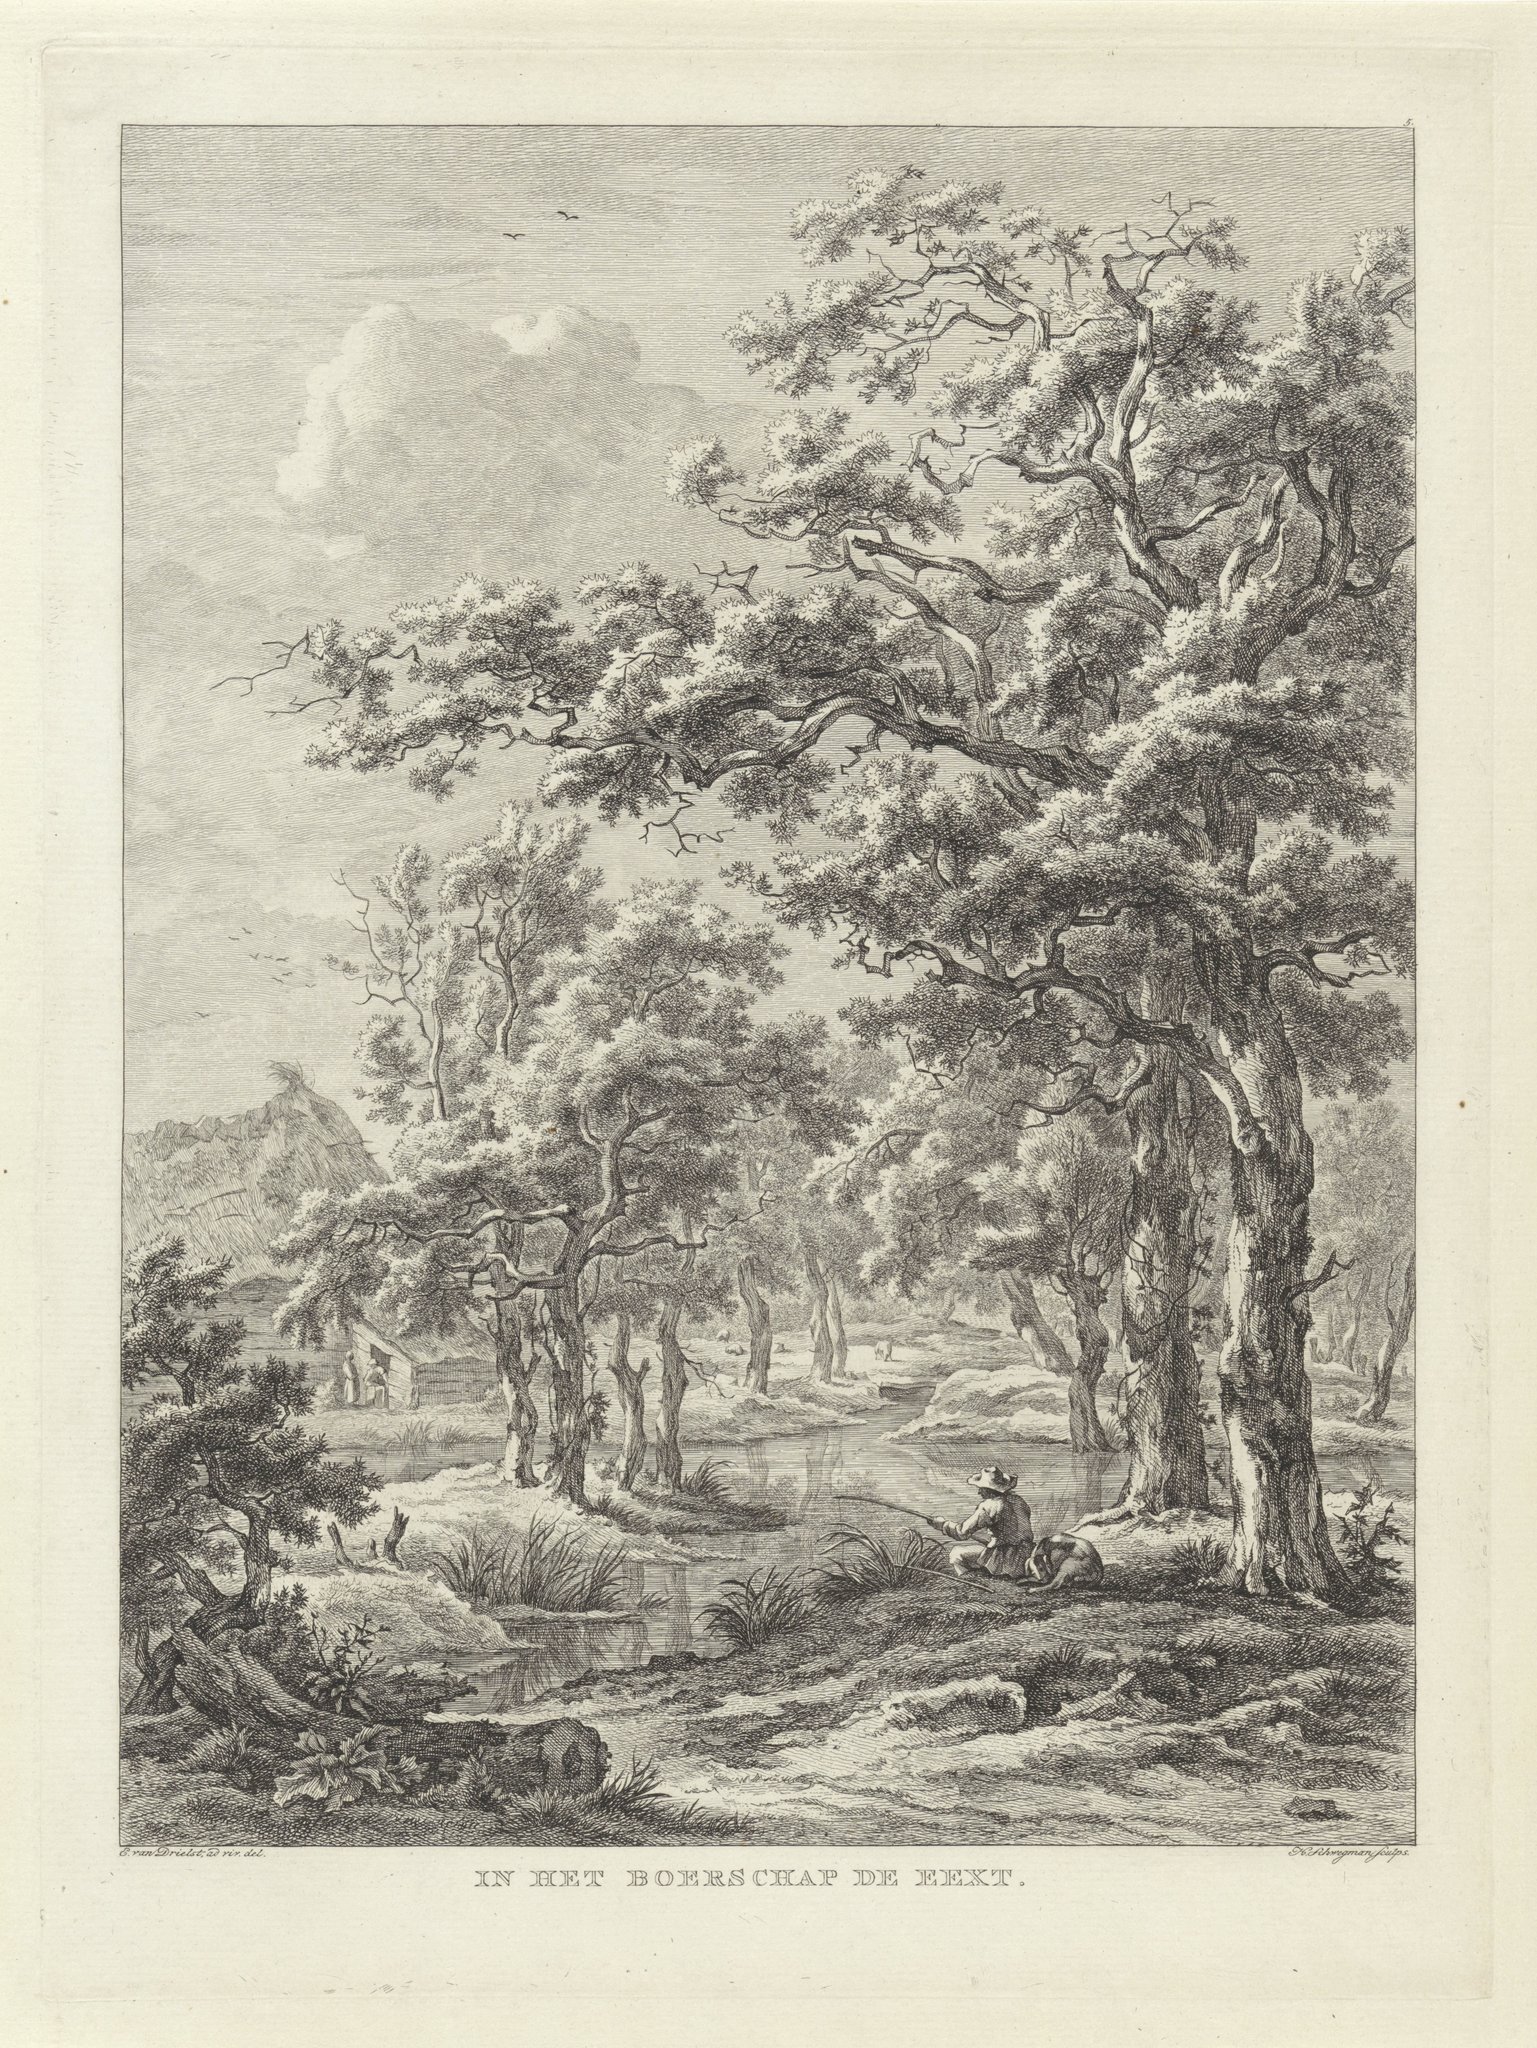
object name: print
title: In het boerschap de Eext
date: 1771-1816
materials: paper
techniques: engraving, etching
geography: eext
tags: angling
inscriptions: collector's mark: Lugt 2228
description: Een hengelaar aan het water in Eext, Drenthe.